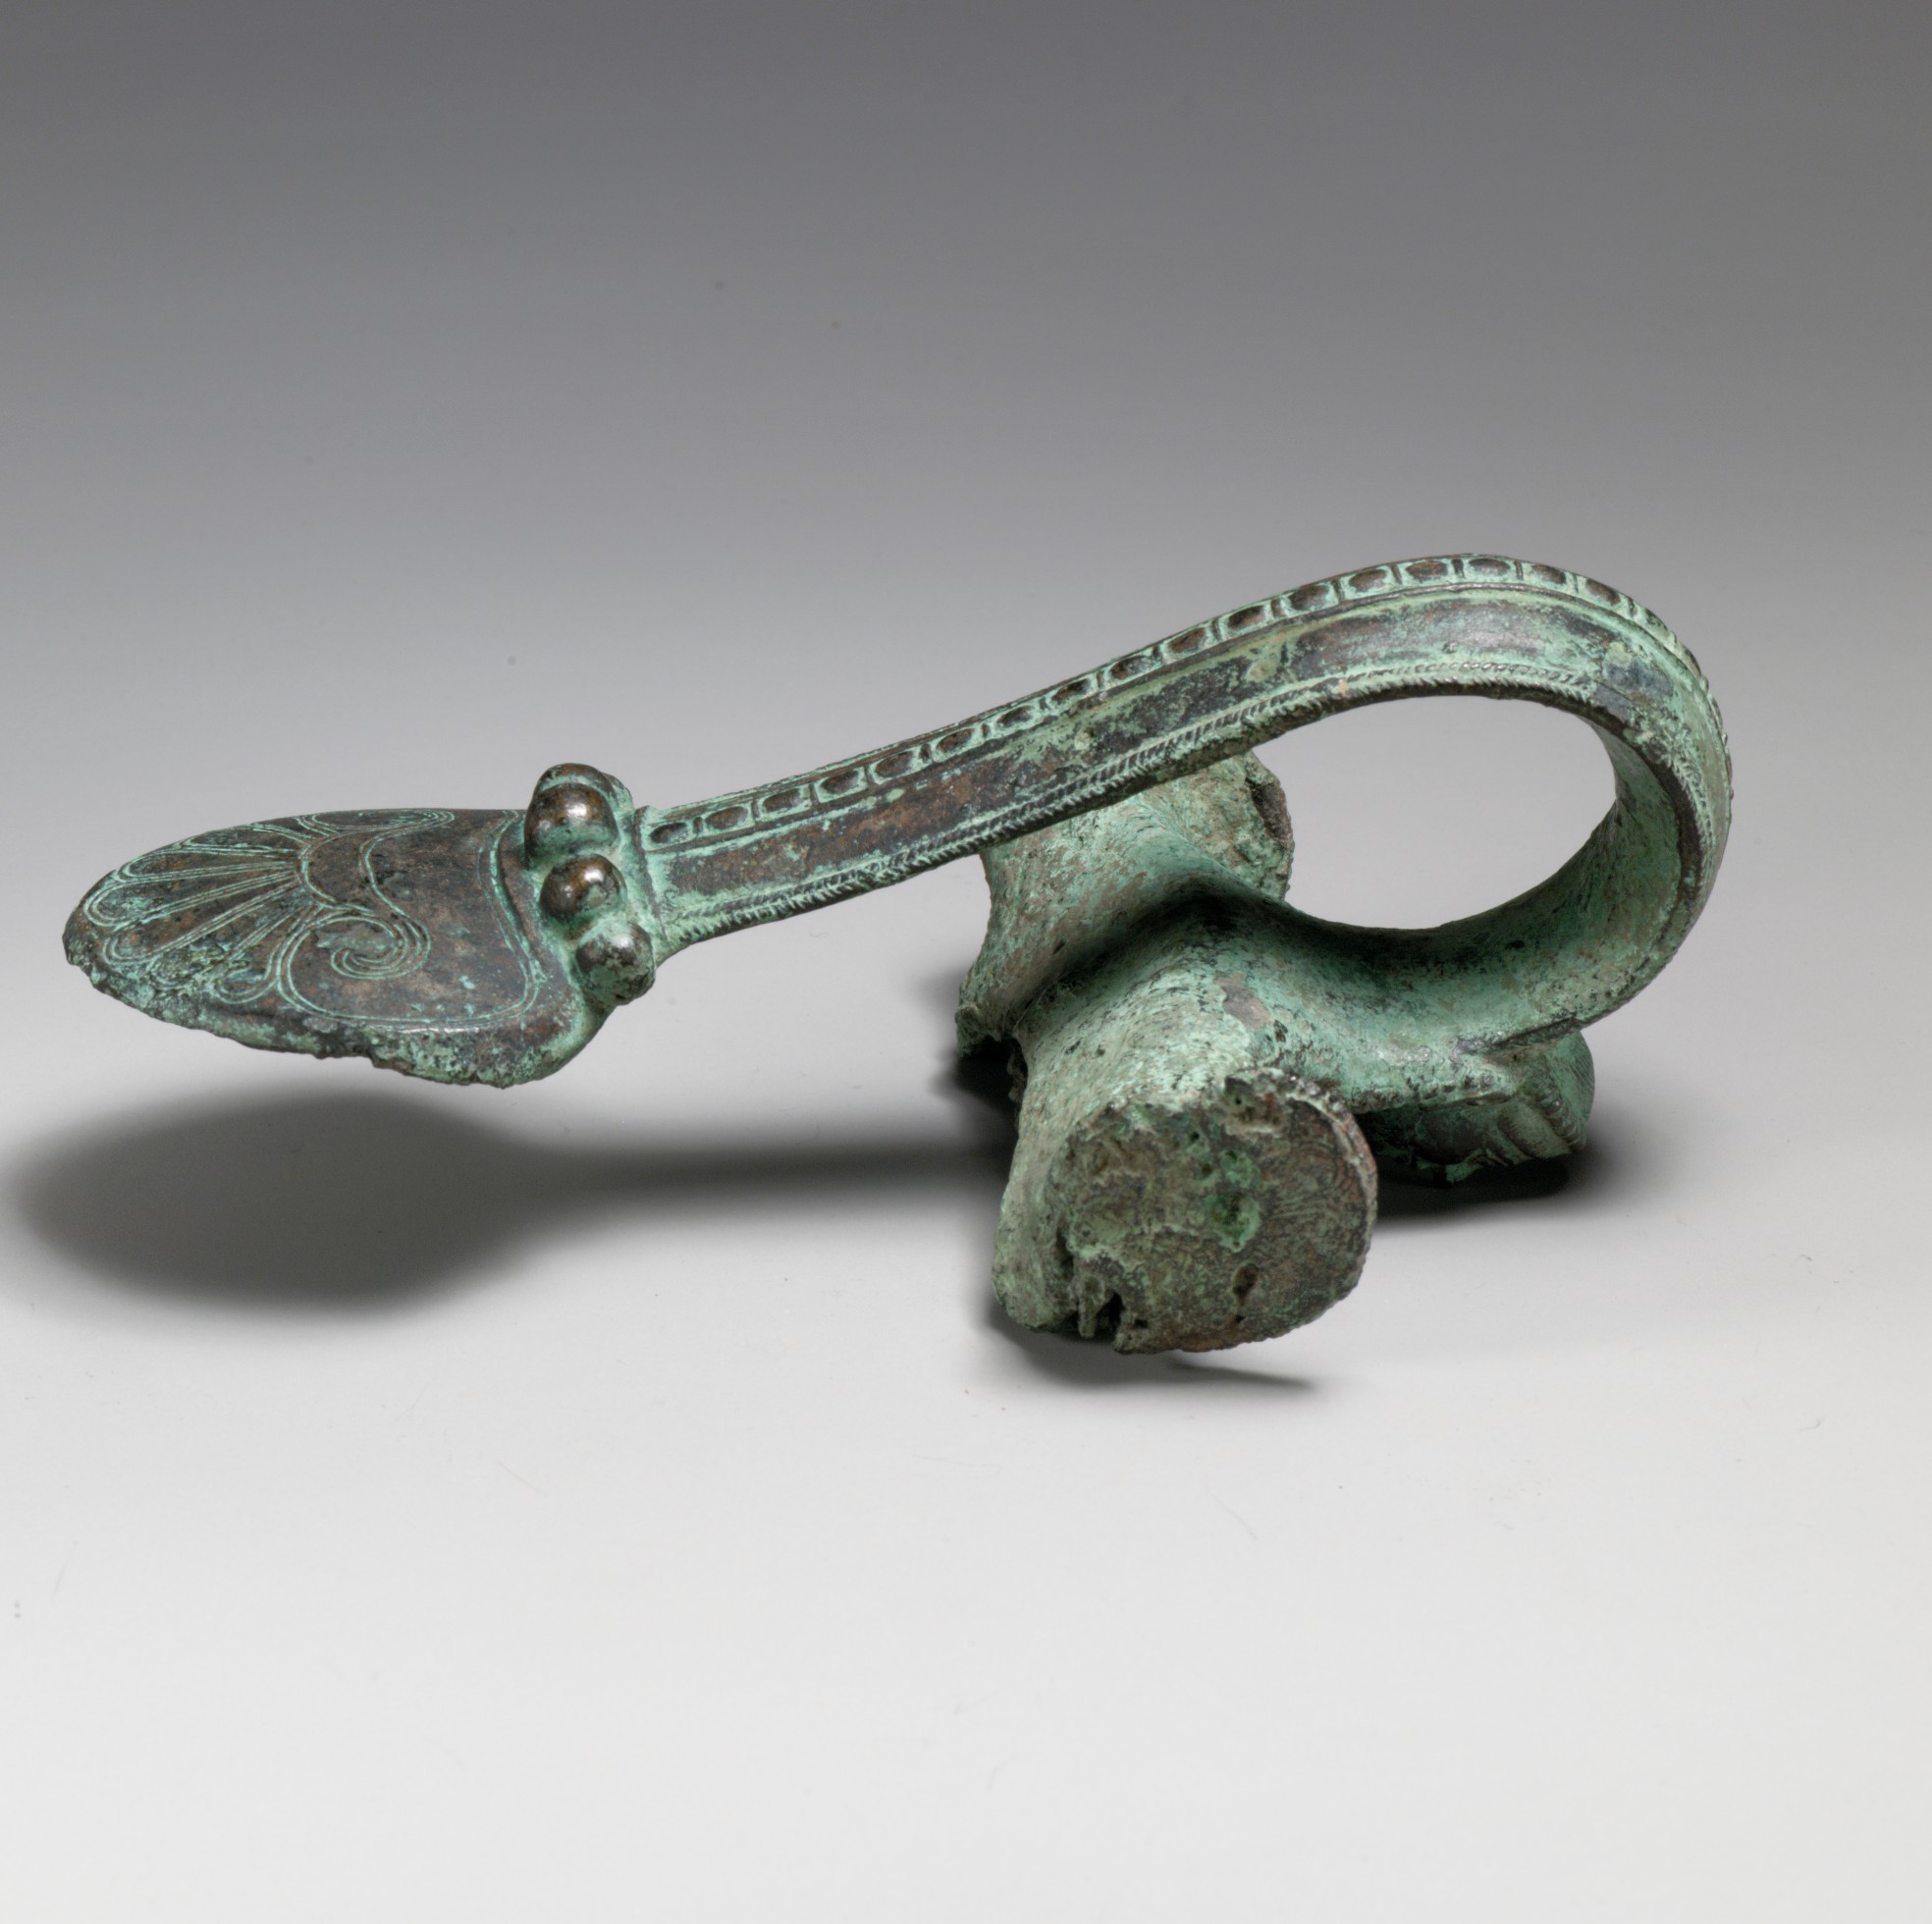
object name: handle with female head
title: Bronze handle of an oinochoe (jug)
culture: greek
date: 534-501 BCE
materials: bronze